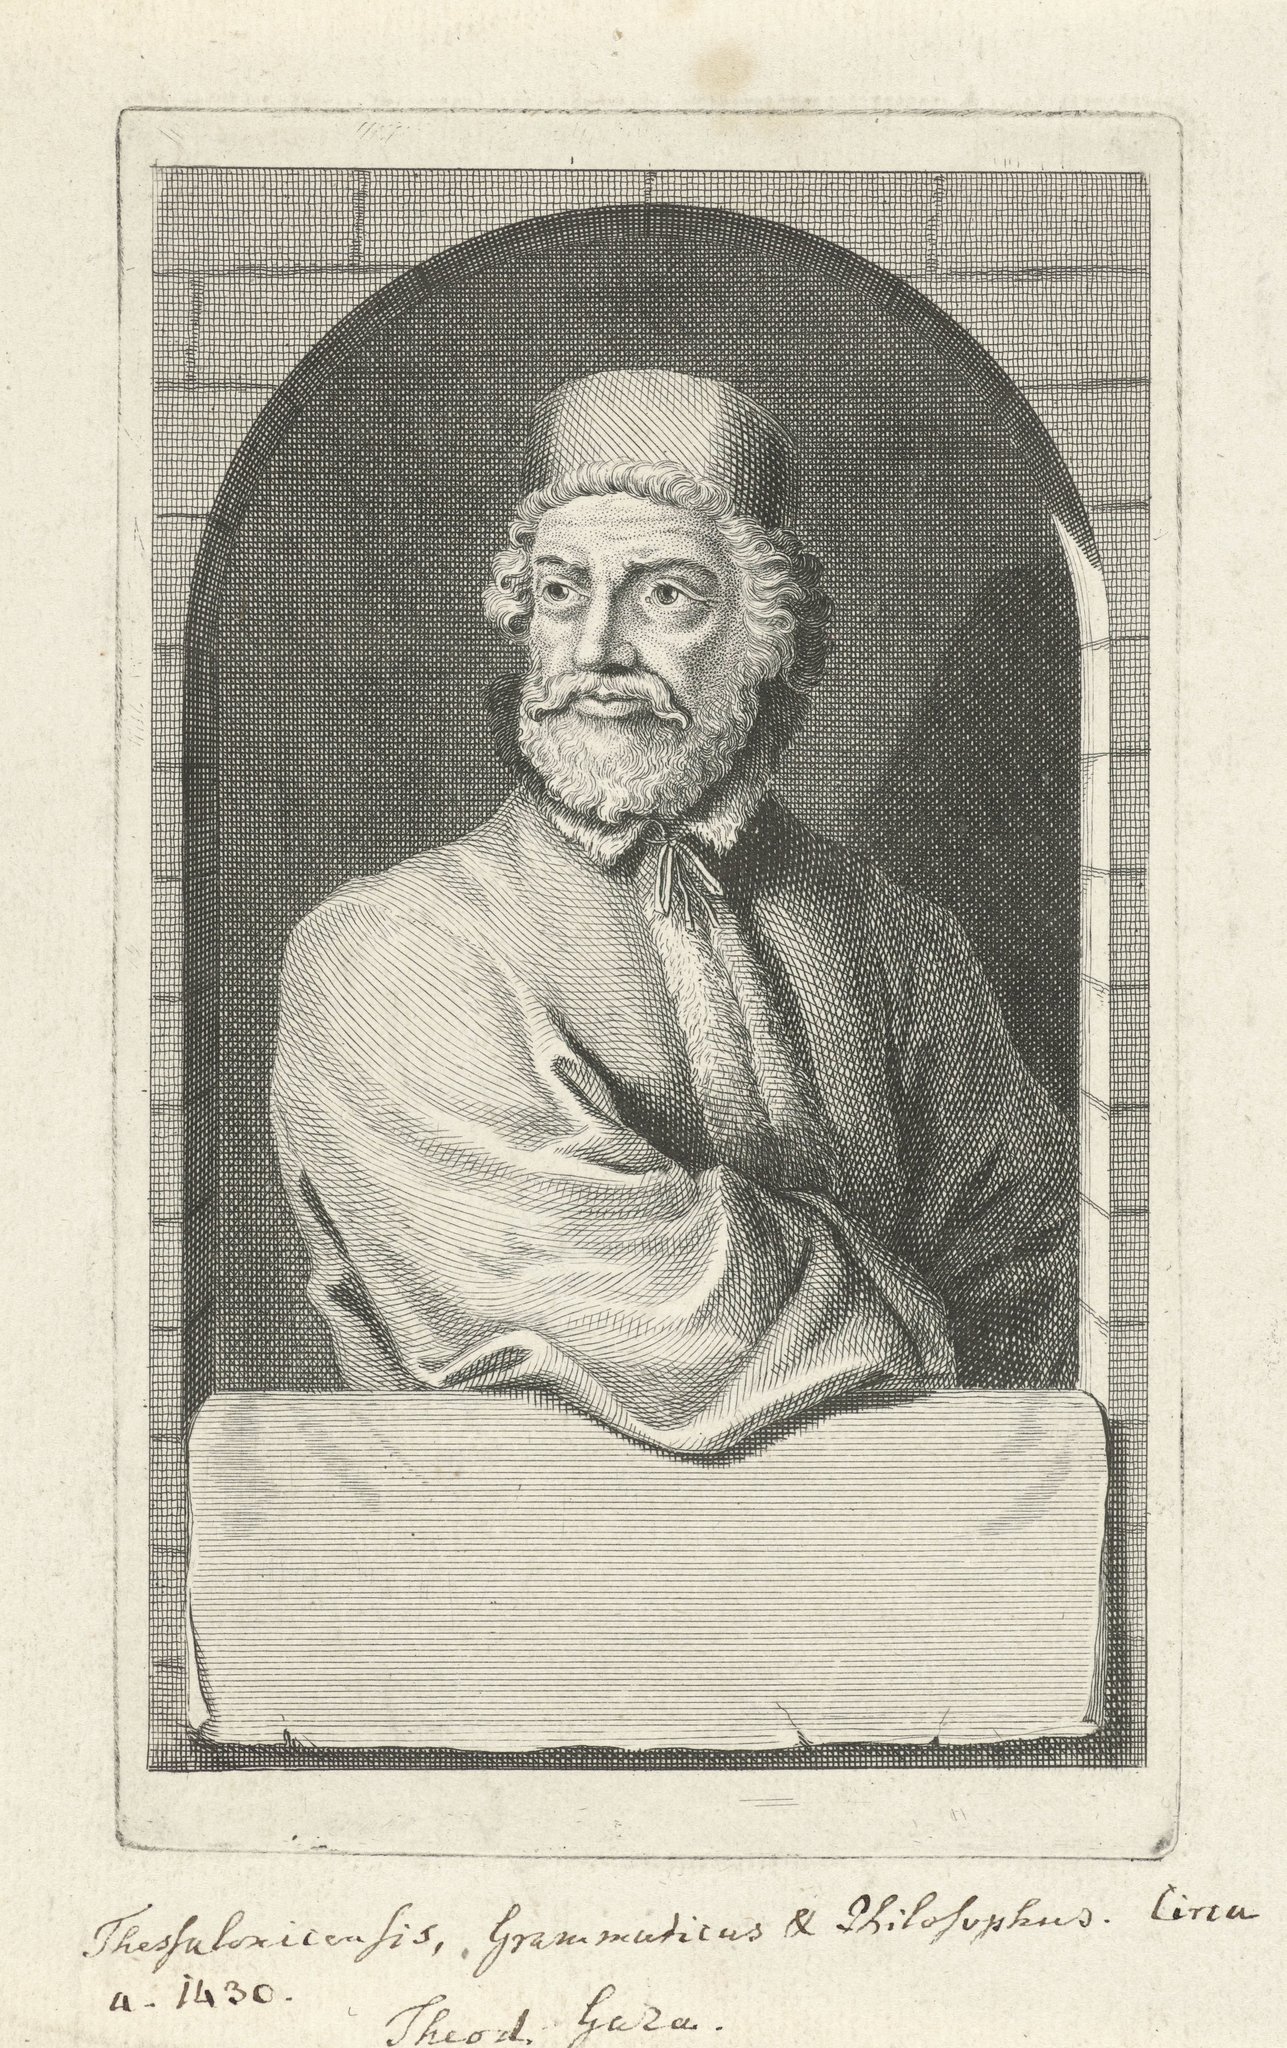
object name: print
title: Portret van Theodorus Gaza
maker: adolf van der laan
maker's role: draughtsman, print maker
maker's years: 1689-1742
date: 1694-1755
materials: paper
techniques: engraving, etching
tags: calabria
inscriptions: inscription: ‘Thessalonicasis [...] Gaza’, collector's mark: Lugt 2228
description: Portretbuste naar rechts van Theodorus Gaza, Grieks geleerde, met hoofddeksel. Met zijn rechter elleboog leunt Gaza op de plint van de toogvormige omlijsting.